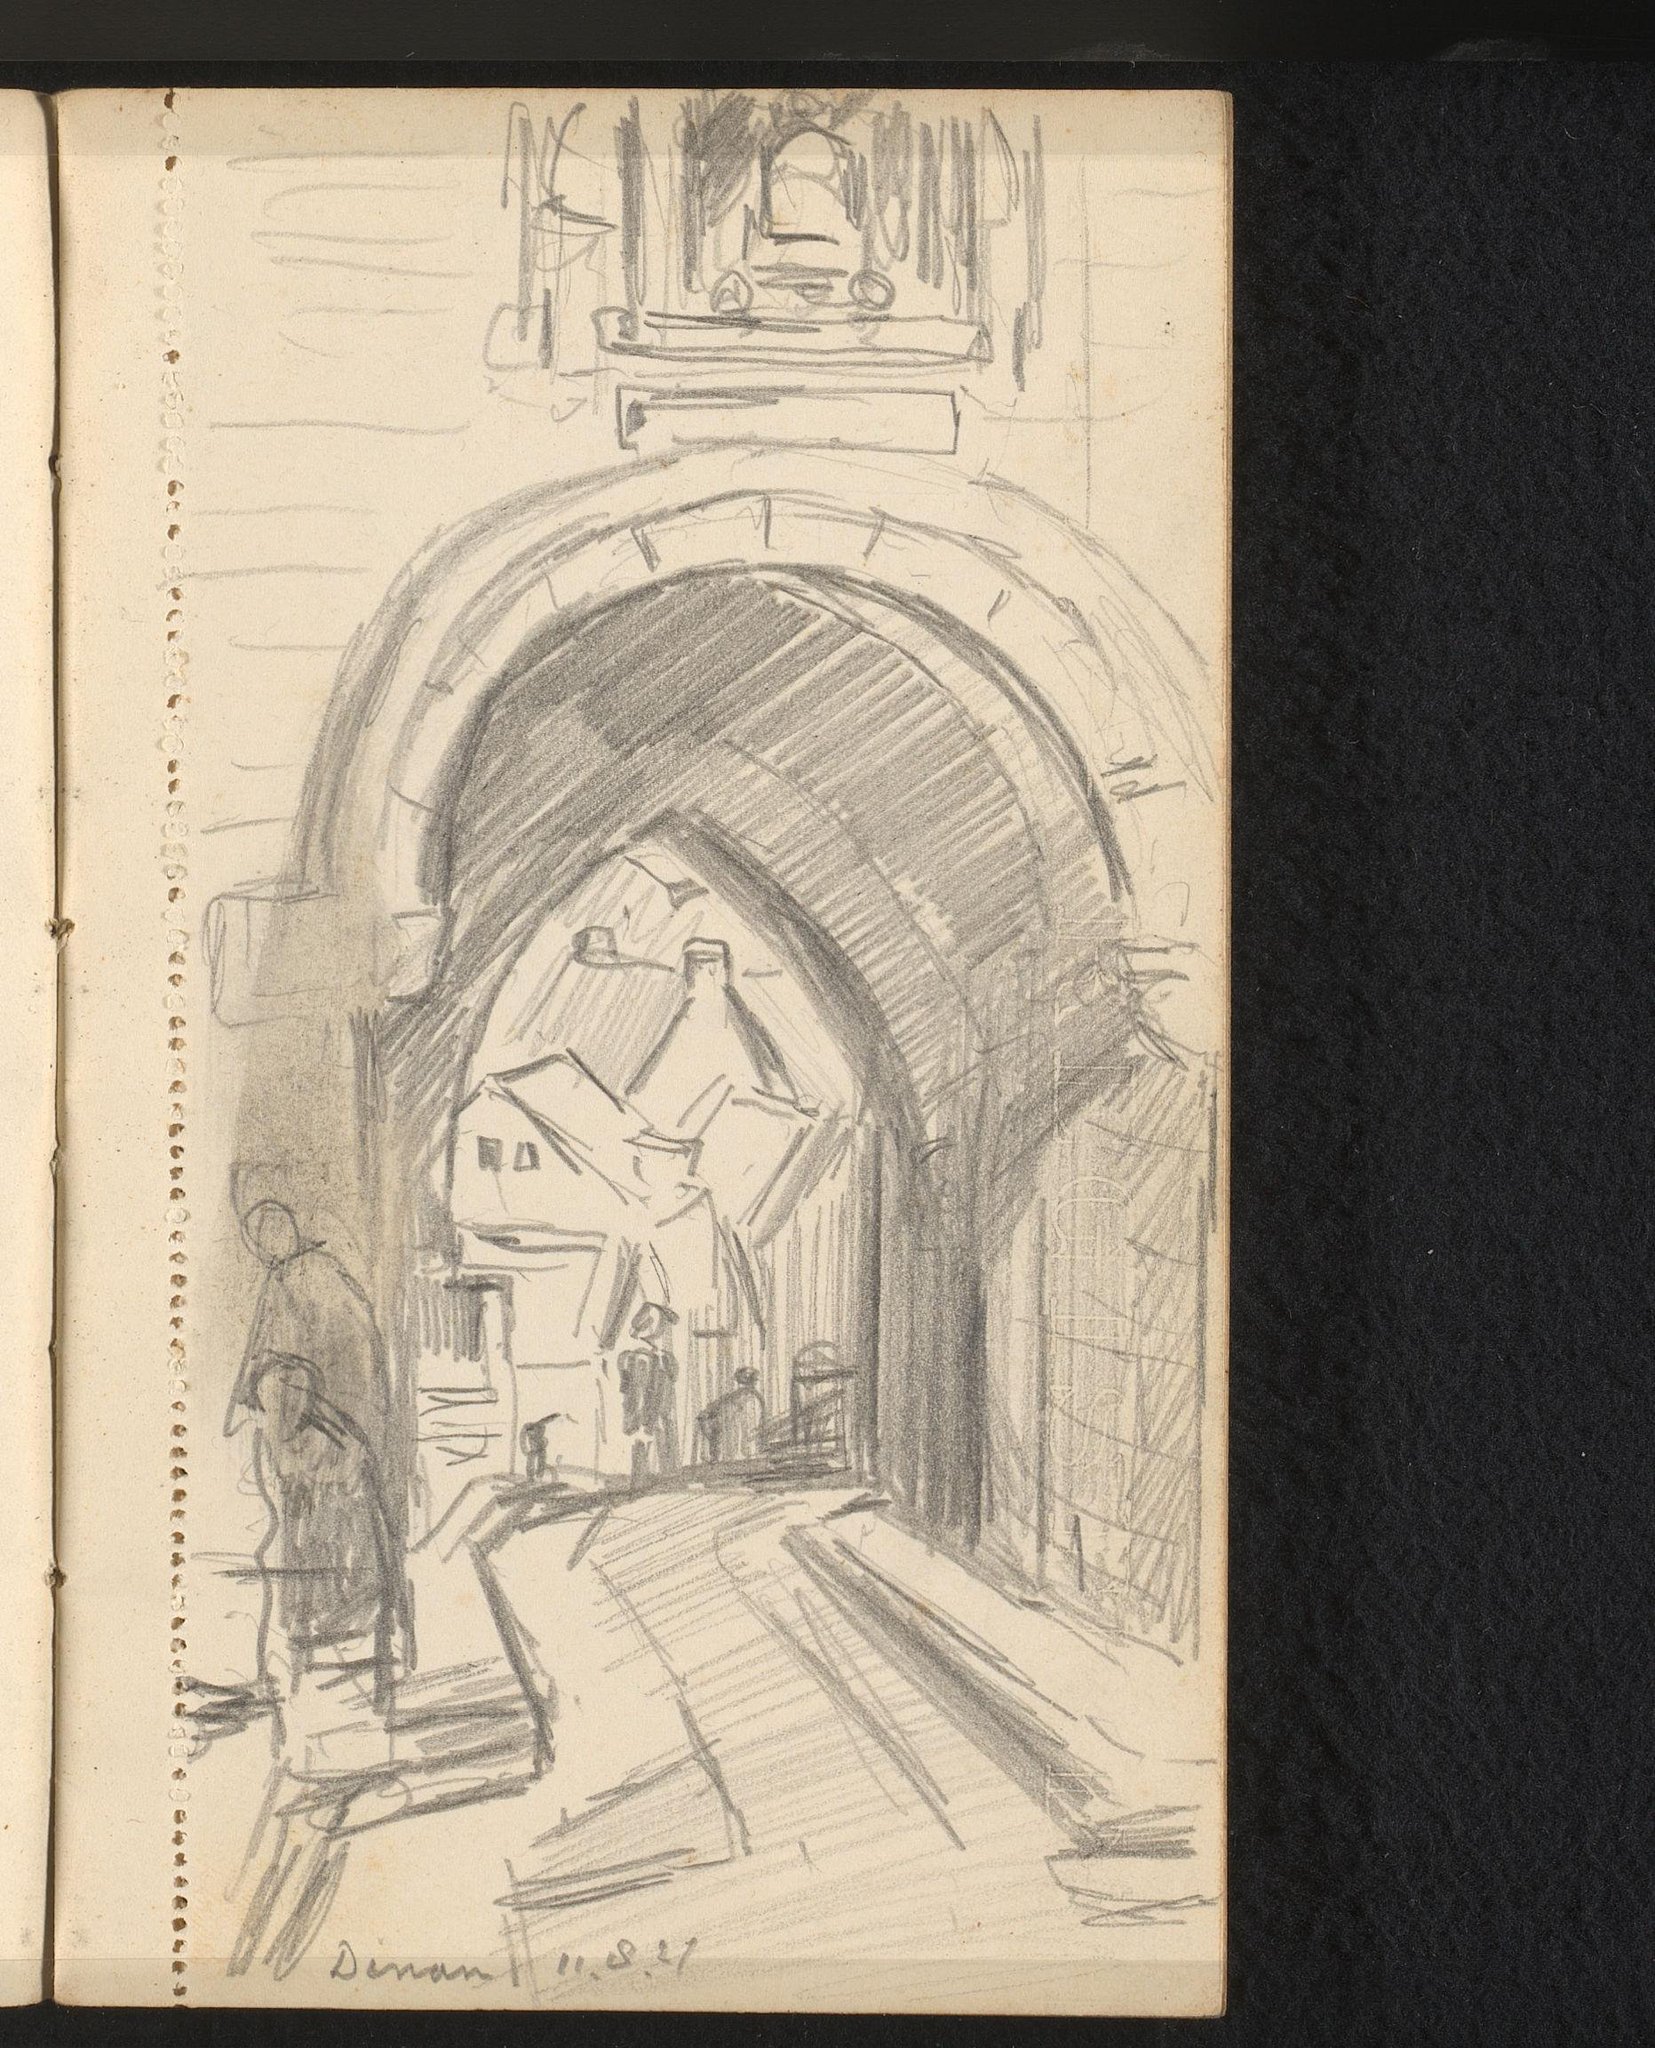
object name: sketchbook leaf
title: Straat met een poort te Dinan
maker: gerrit van blaaderen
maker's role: draughtsman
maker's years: 1873-1935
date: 1927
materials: paper, pencil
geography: dinan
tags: street (+ city(-scape) with figures, staffage)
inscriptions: date and inscription: ‘Dinan 11.8.27’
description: Blad 5 recto uit een schetsboek met 33 bladen.